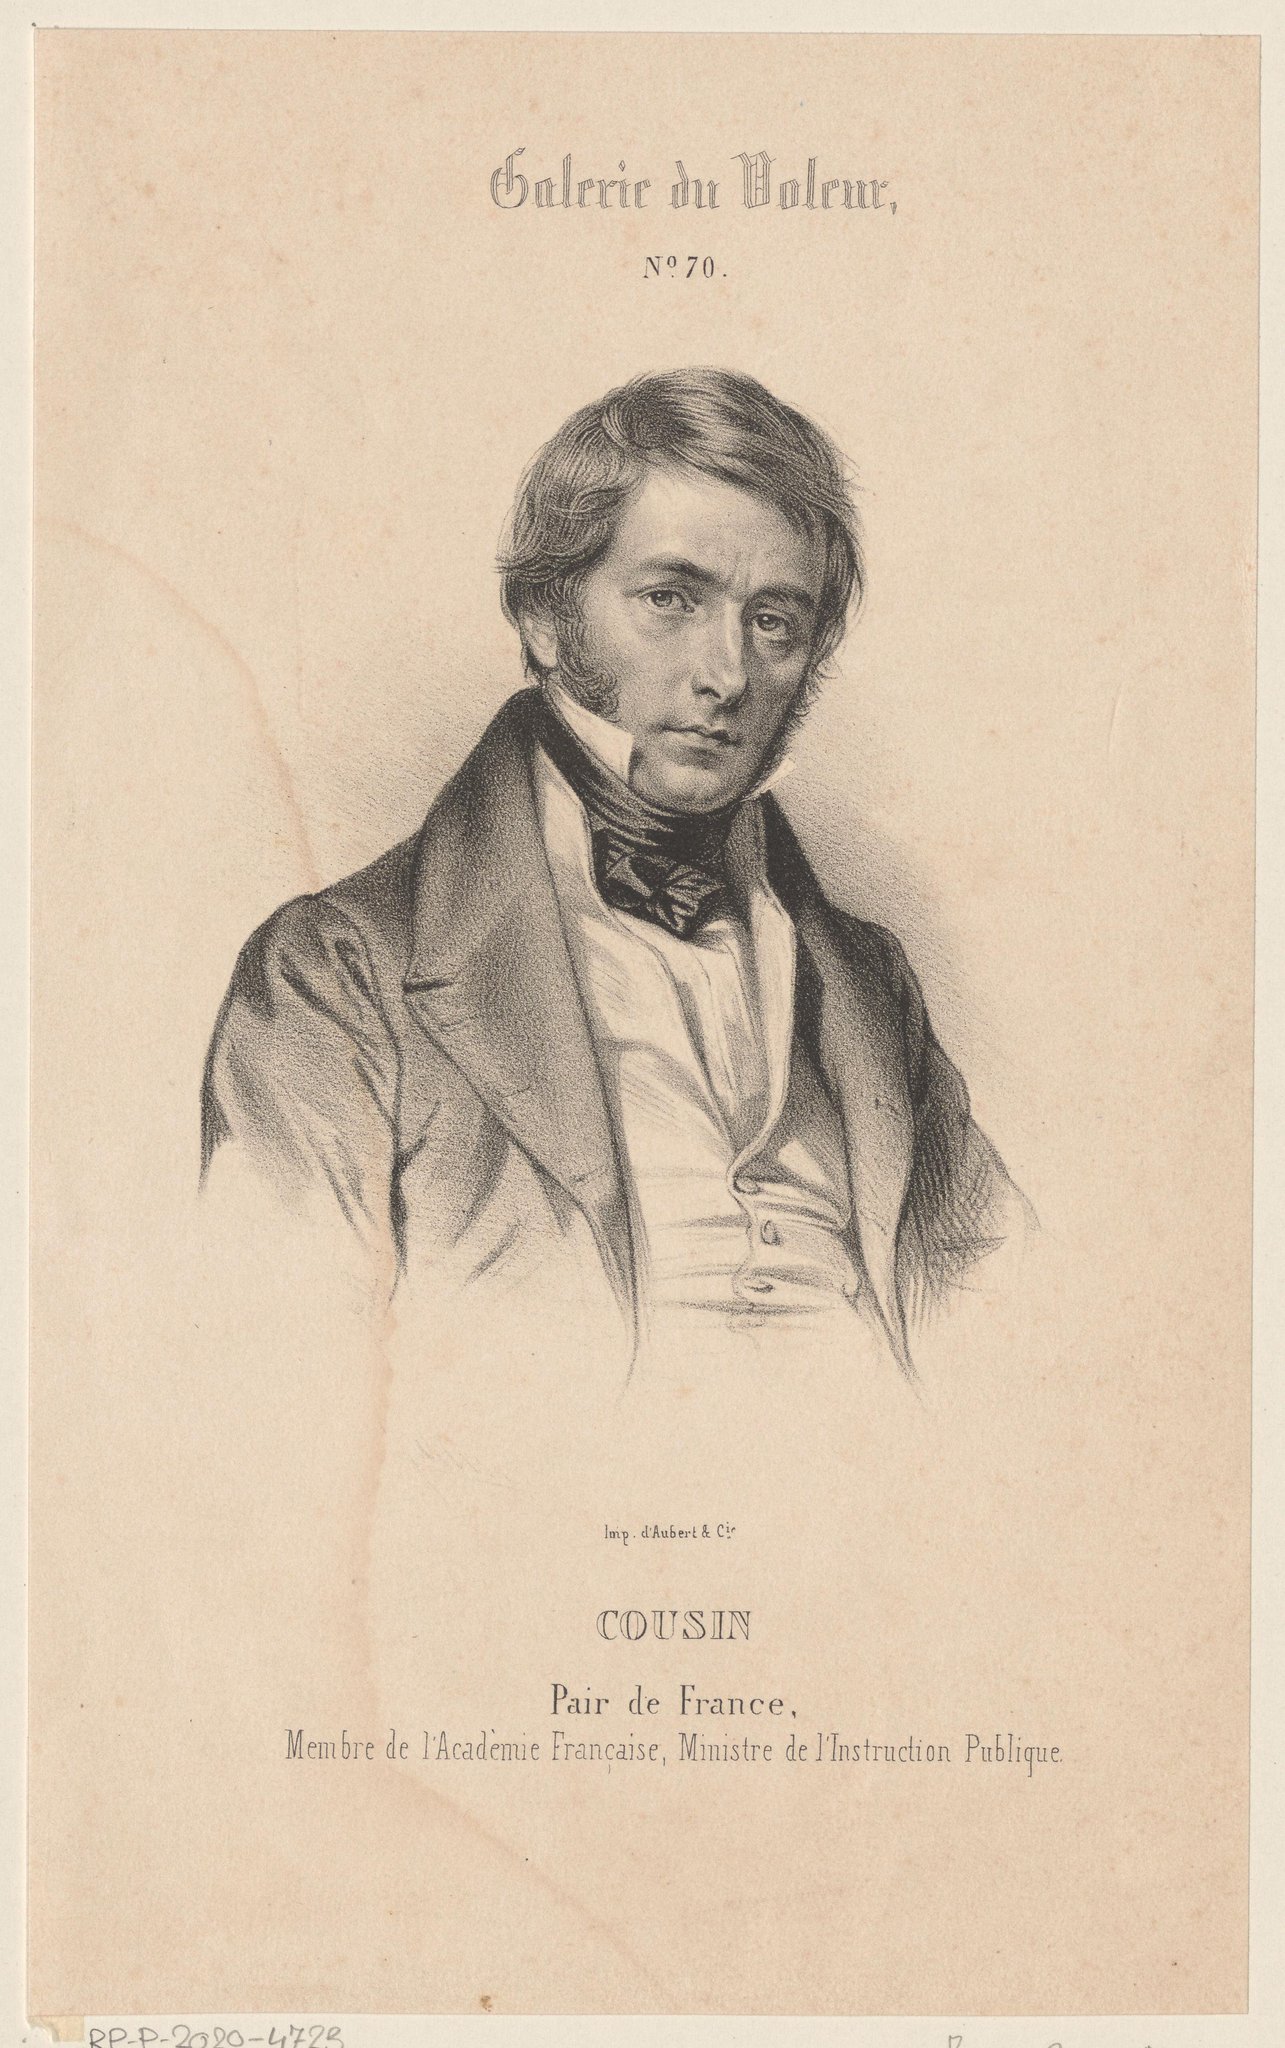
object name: print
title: Portret van Victor Cousin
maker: Anonymous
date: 1840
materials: paper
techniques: lithograph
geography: paris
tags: paris, portrait, self-portrait of painter